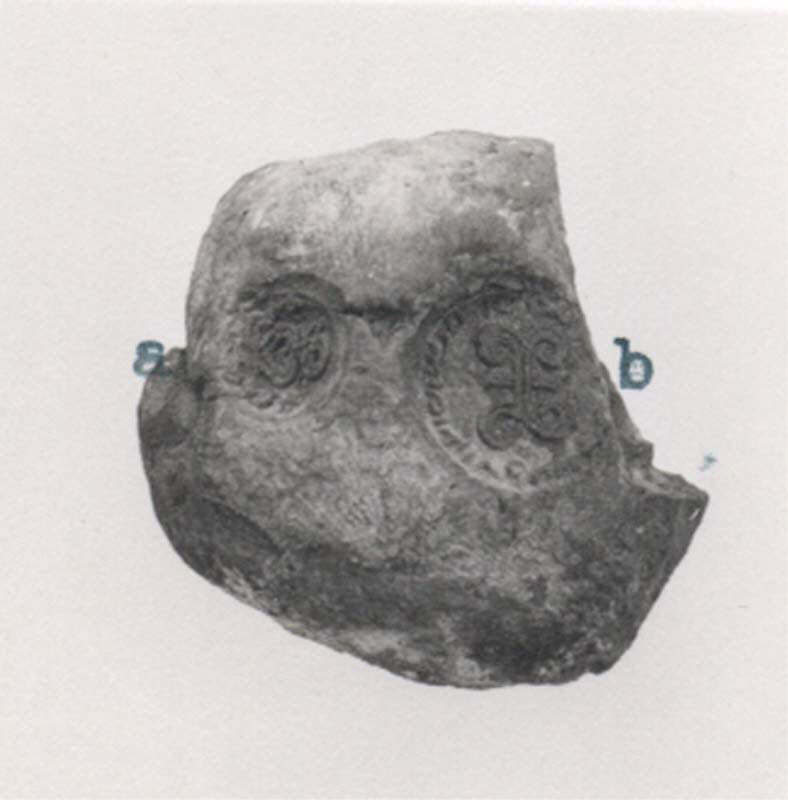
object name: sealing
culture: sasanian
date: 601-700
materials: clay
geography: iran